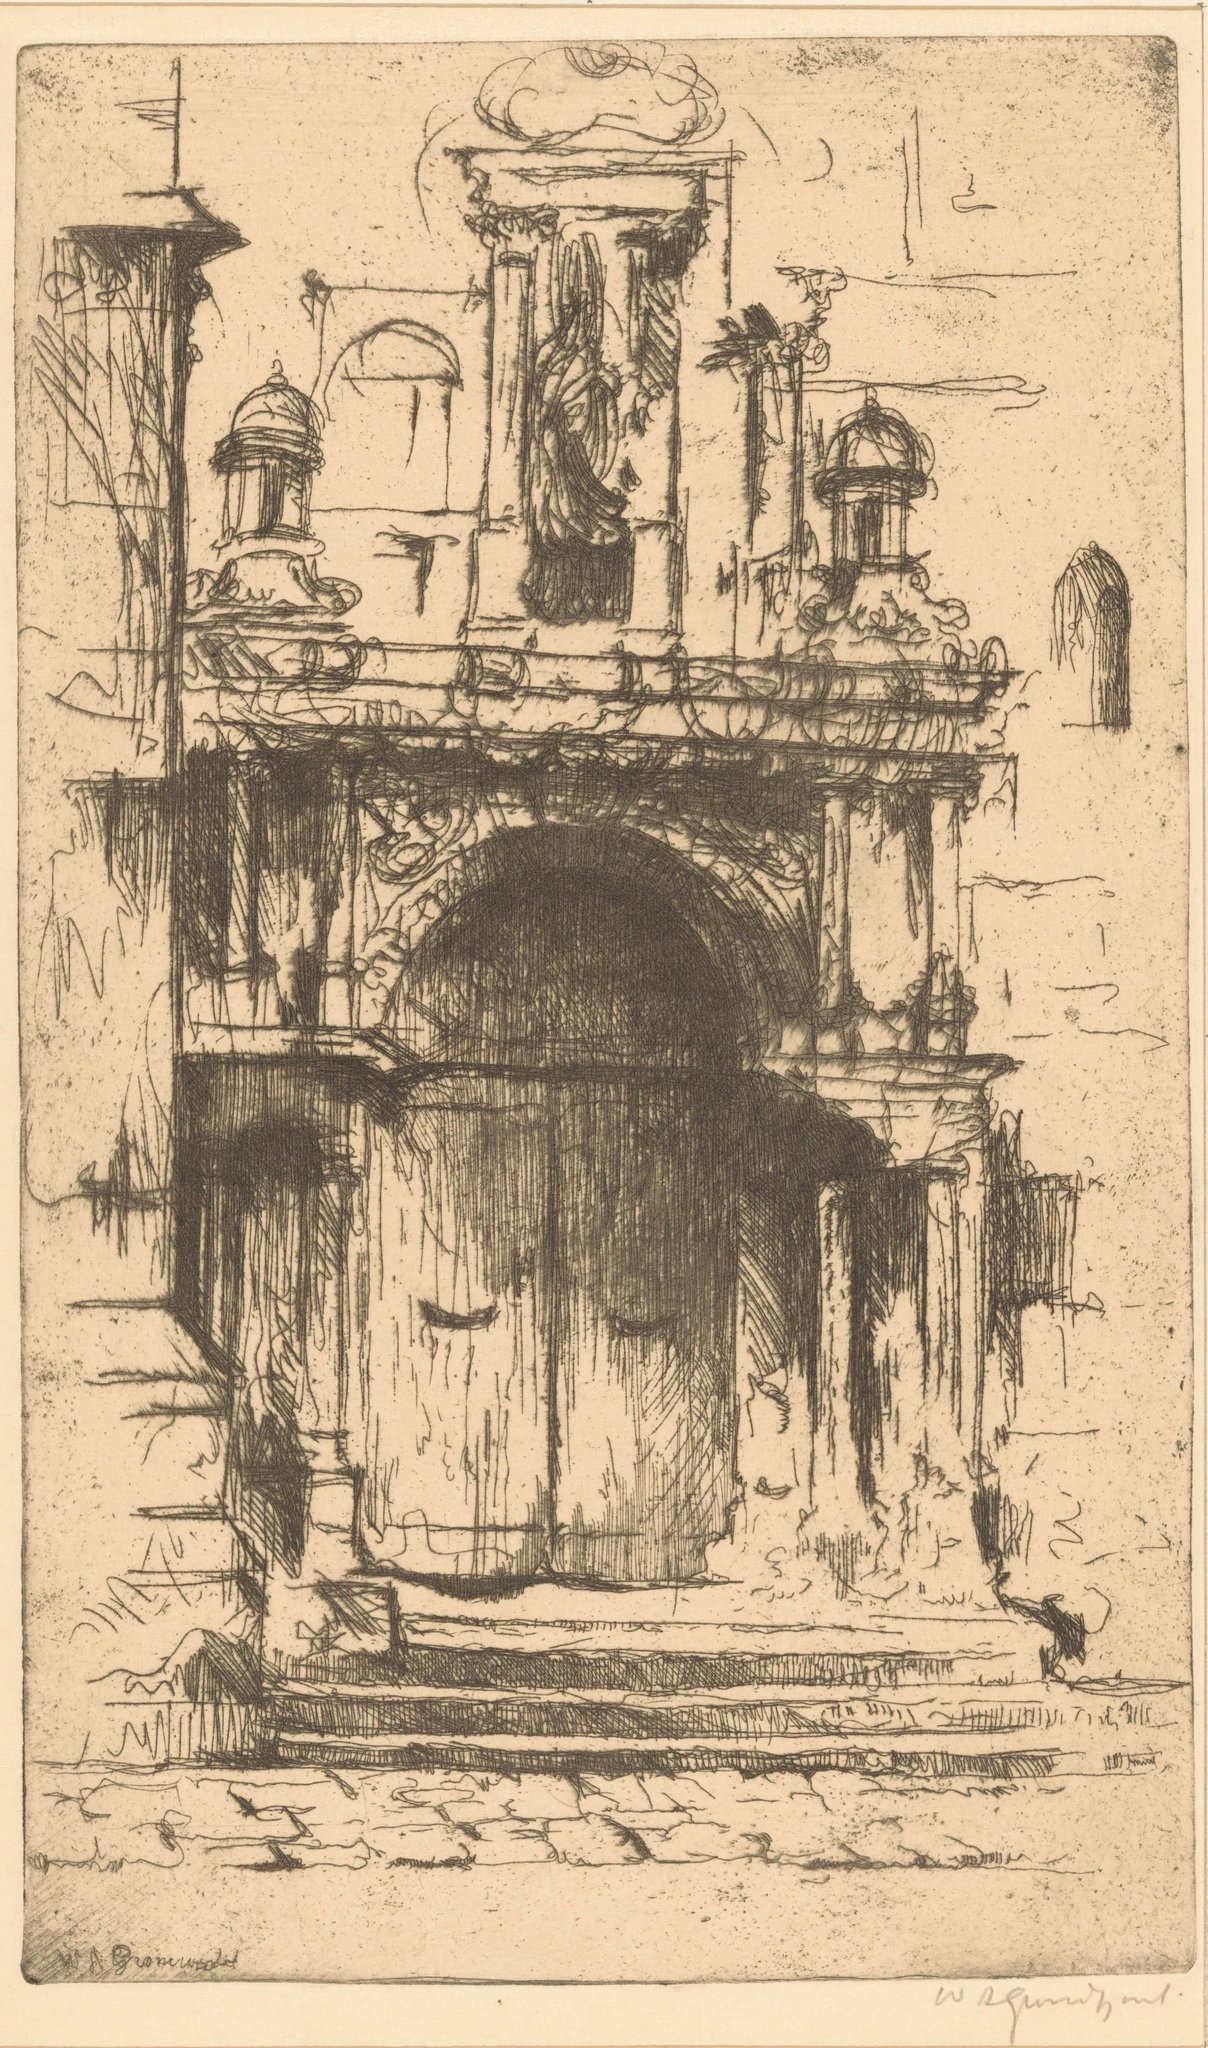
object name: print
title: Église Saint-Aignan in Chartres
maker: willem adrianus grondhout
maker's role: draughtsman, painter, print maker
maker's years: 1878-1934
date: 1888-1934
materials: paper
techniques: etching, intaglio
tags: parts of church exterior and annexes: portal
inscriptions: collector's mark: Lugt 2228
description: Een portaal in de voorgevel van de Église Saint-Aignan in Chartres.